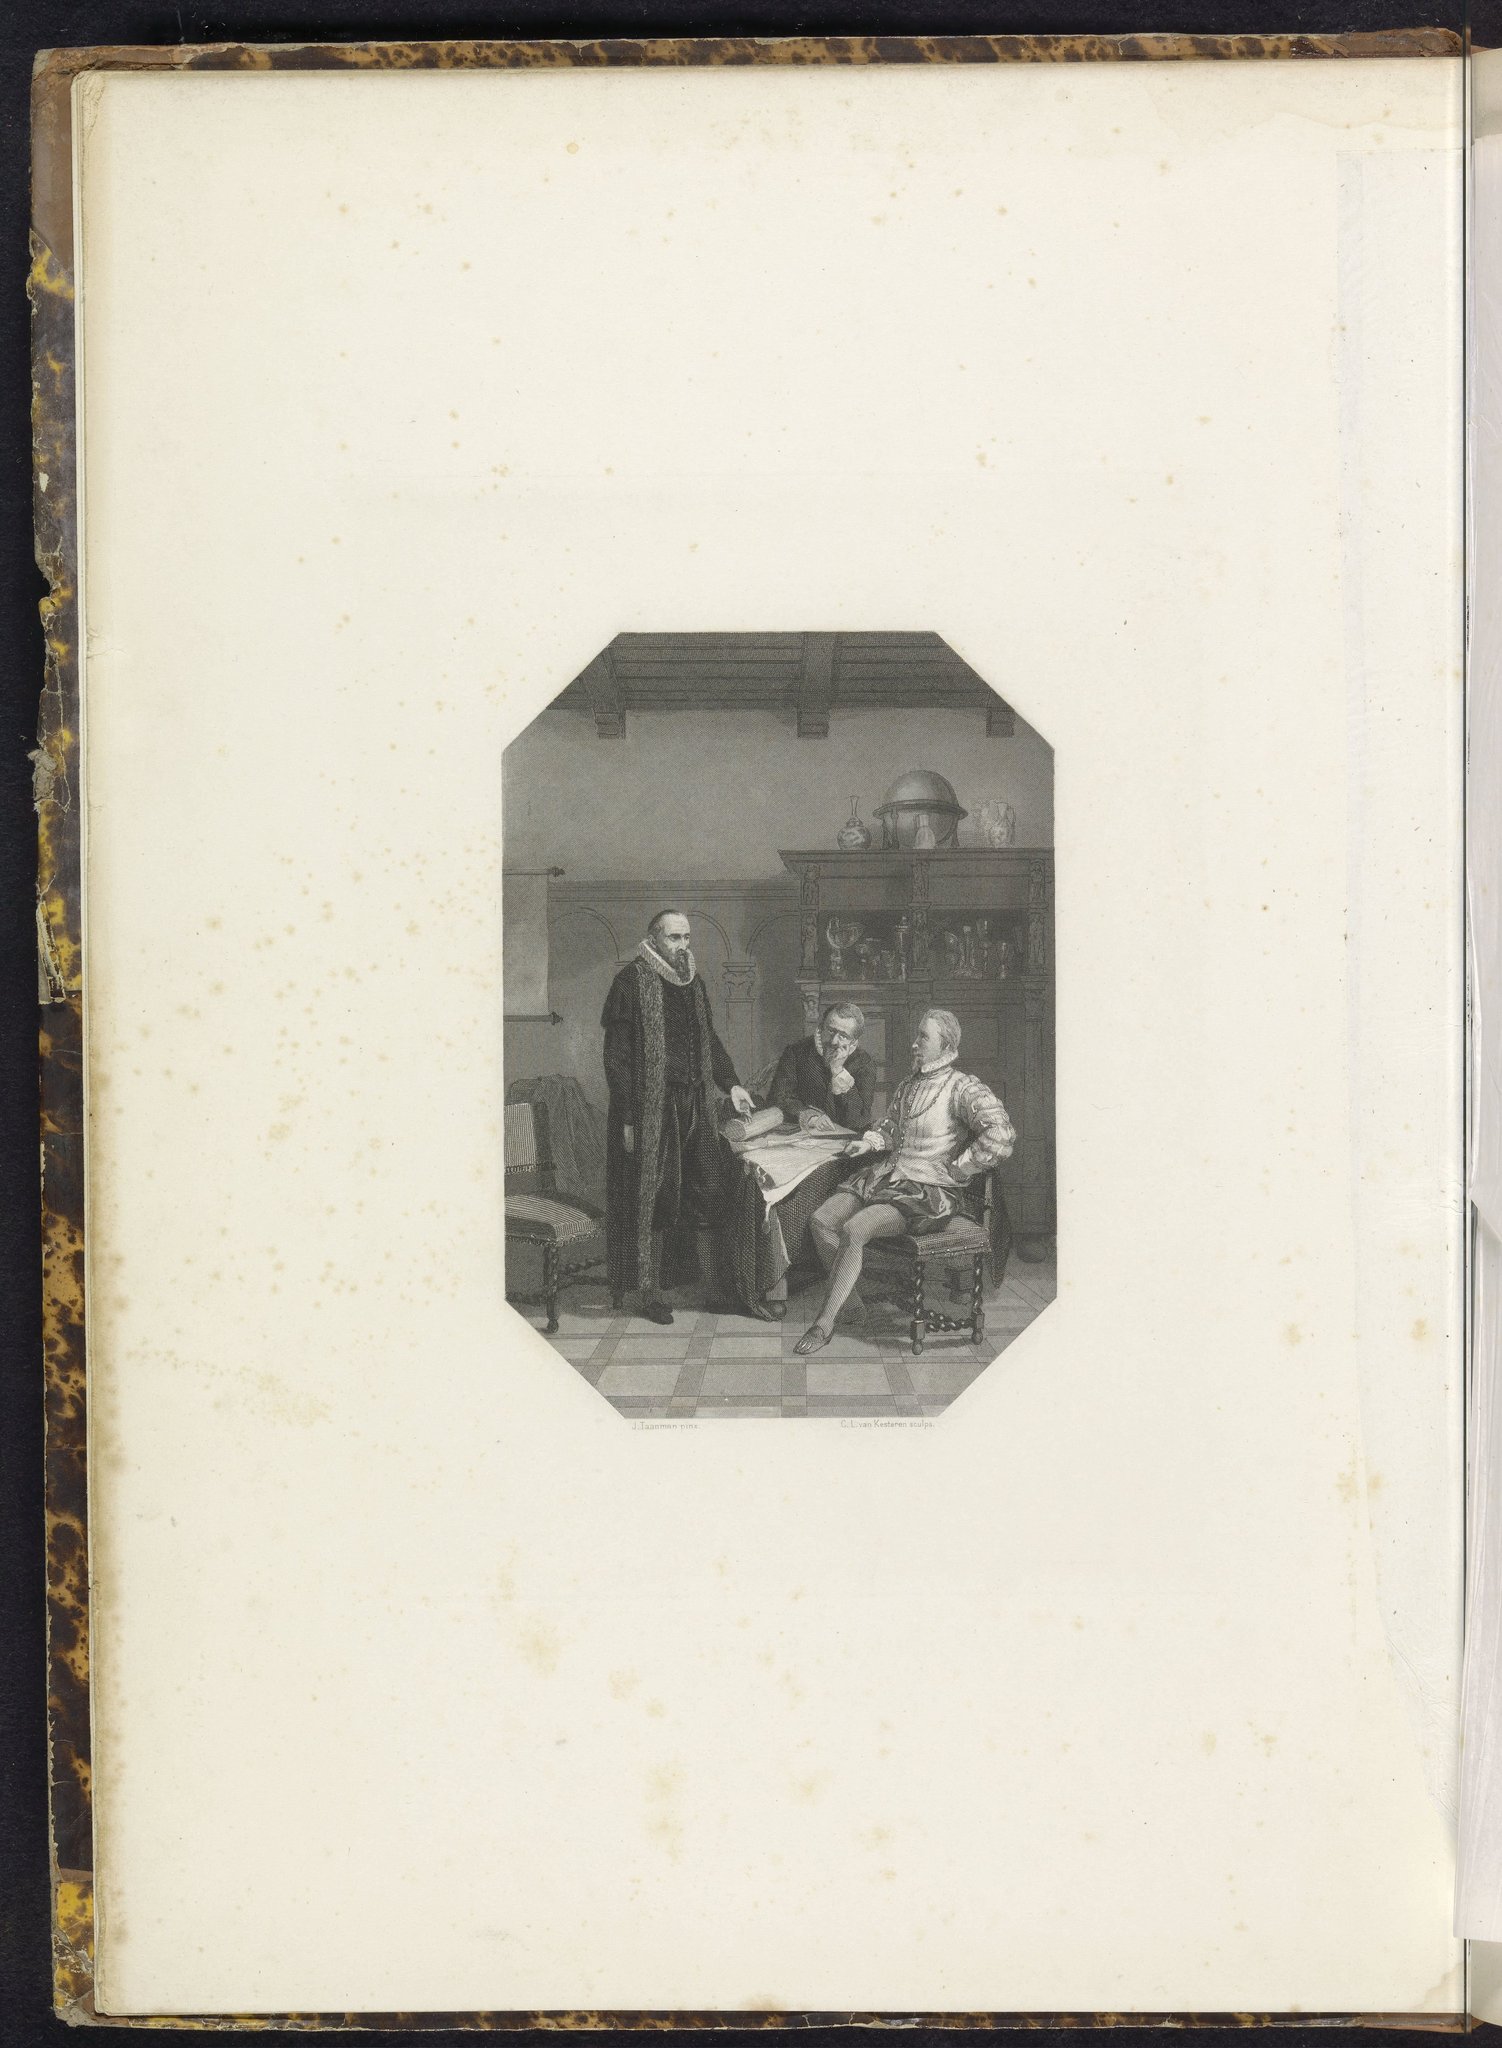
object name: history print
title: Leicester en Oldenbarnevelt, 1586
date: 1865-1870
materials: paper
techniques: engraving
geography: netherlands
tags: the hague, johan van oldenbarnevelt, robert dudley (1st earl of leicester)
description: Ontmoeting tussen de graaf van Leicester en Johan van Oldenbarnevelt, 1586. Onderdeel van de groep staalgravures naar de schilderijen van de Historische Galerij der Maatschappij Arti et Amicitiae.